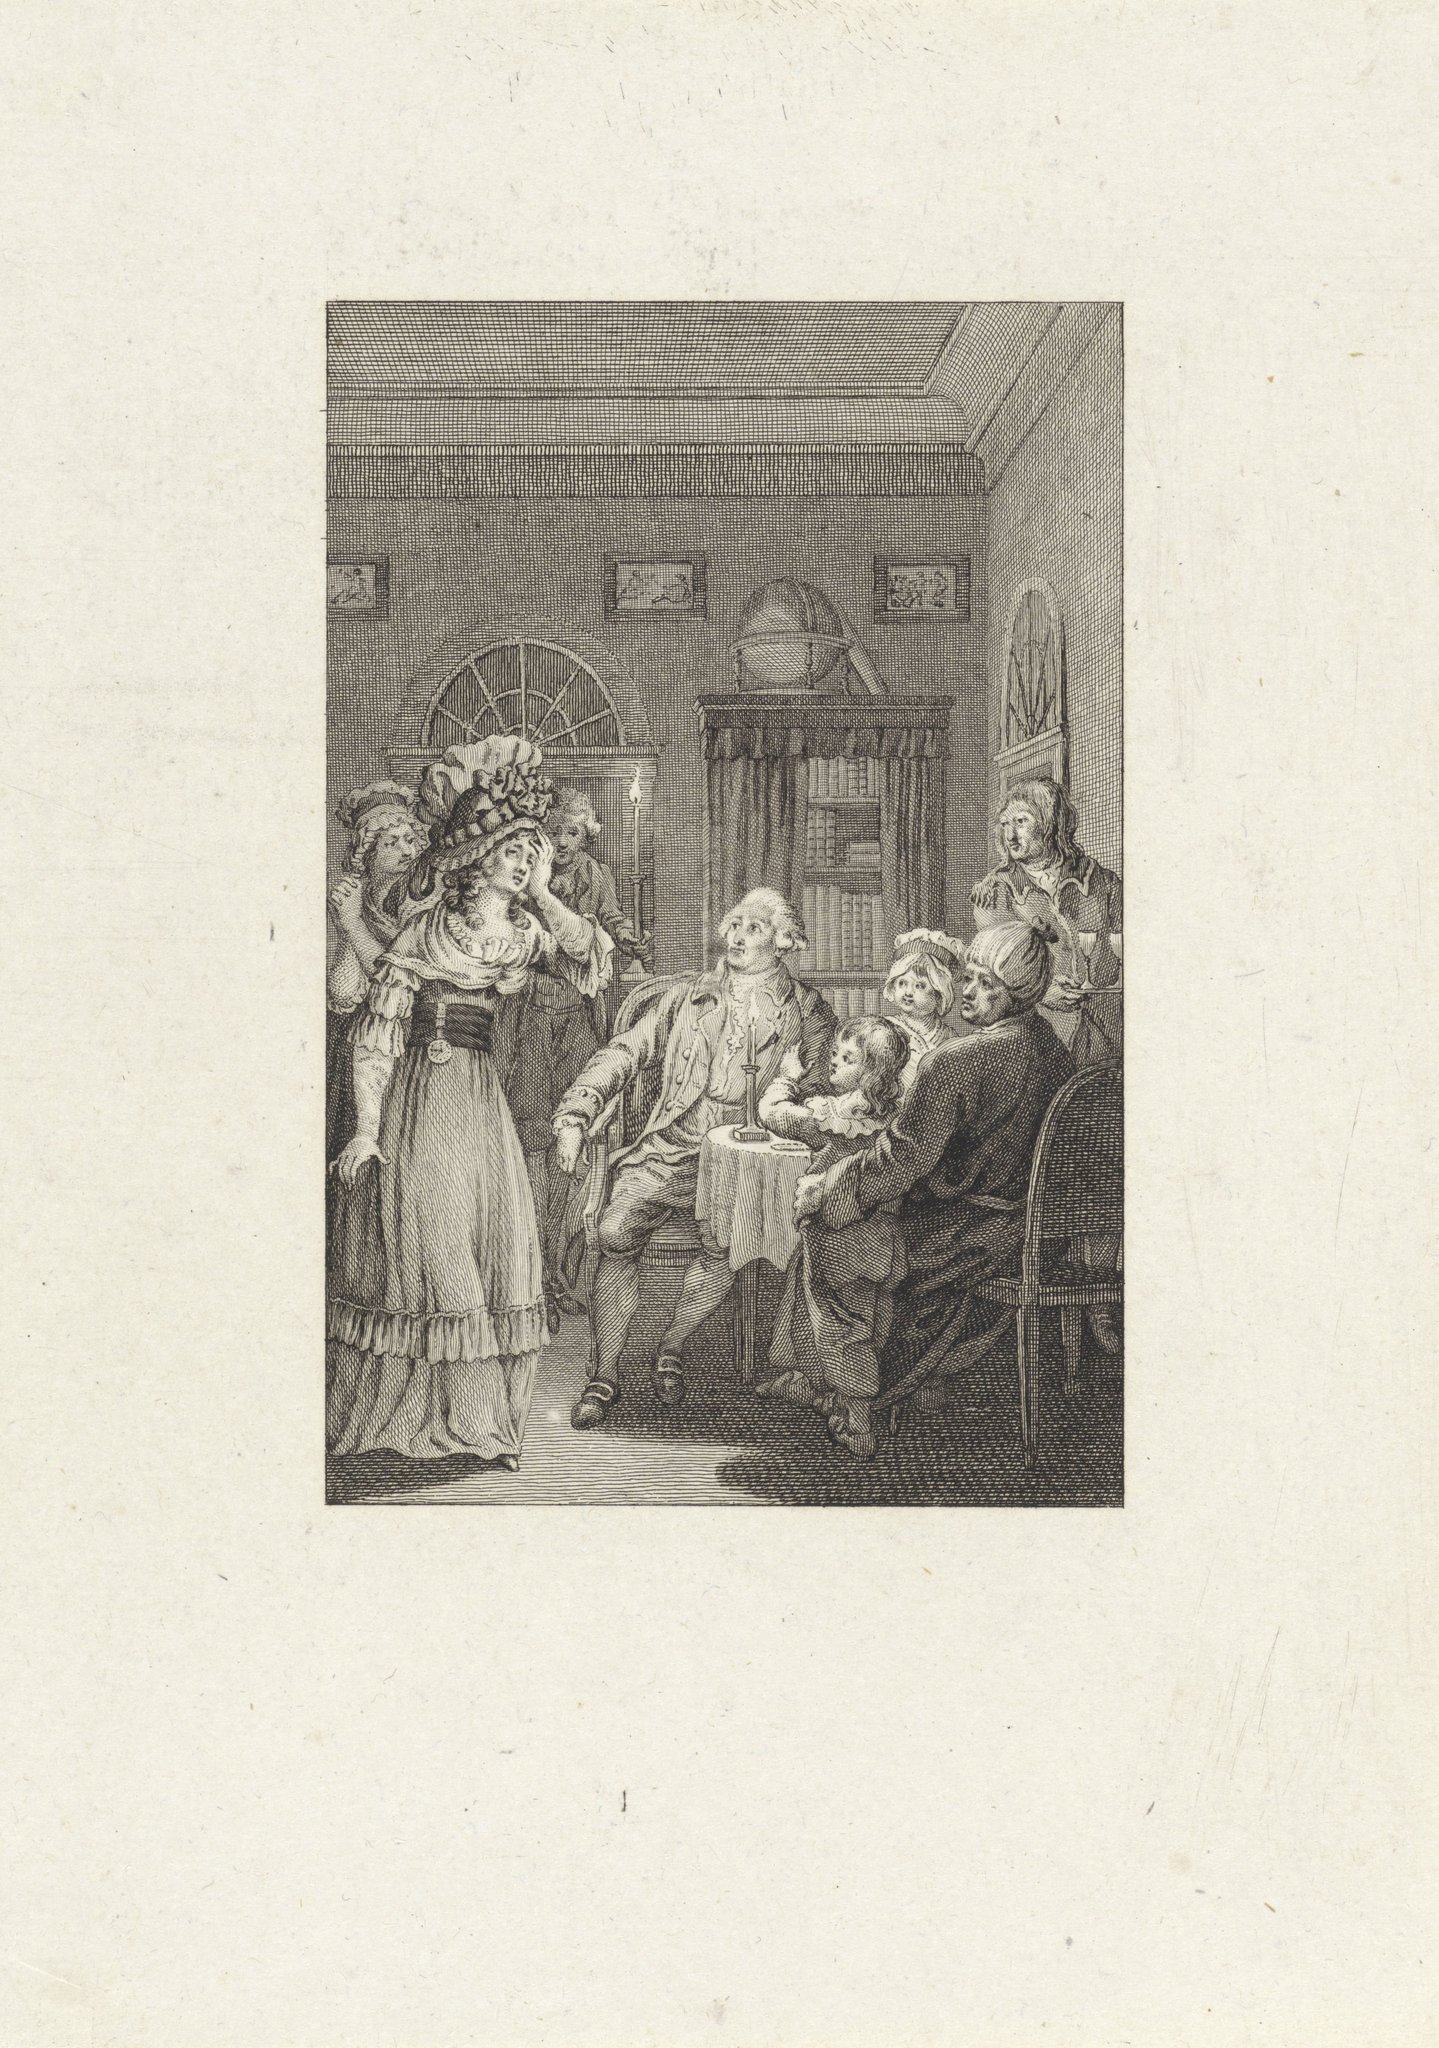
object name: print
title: Mevrouw de Florville in verwondering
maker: reinier vinkeles (i)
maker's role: draughtsman, print maker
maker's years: 1741-1816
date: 1751-1816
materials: paper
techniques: engraving, etching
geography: amsterdam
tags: surprise, wonder; 'maraviglia' (ripa) (+ variant)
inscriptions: collector's mark: Lugt 240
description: Deze prent is een proefdruk van een prent die ook gebruikt is als illustratie in: Spectatoriaale schouwburg, behelzende eene verzameling der beste (...), deel 19. Amsterdam: erven van Pieter Meijer en Gerrit Warnars, 1790, p. 326.